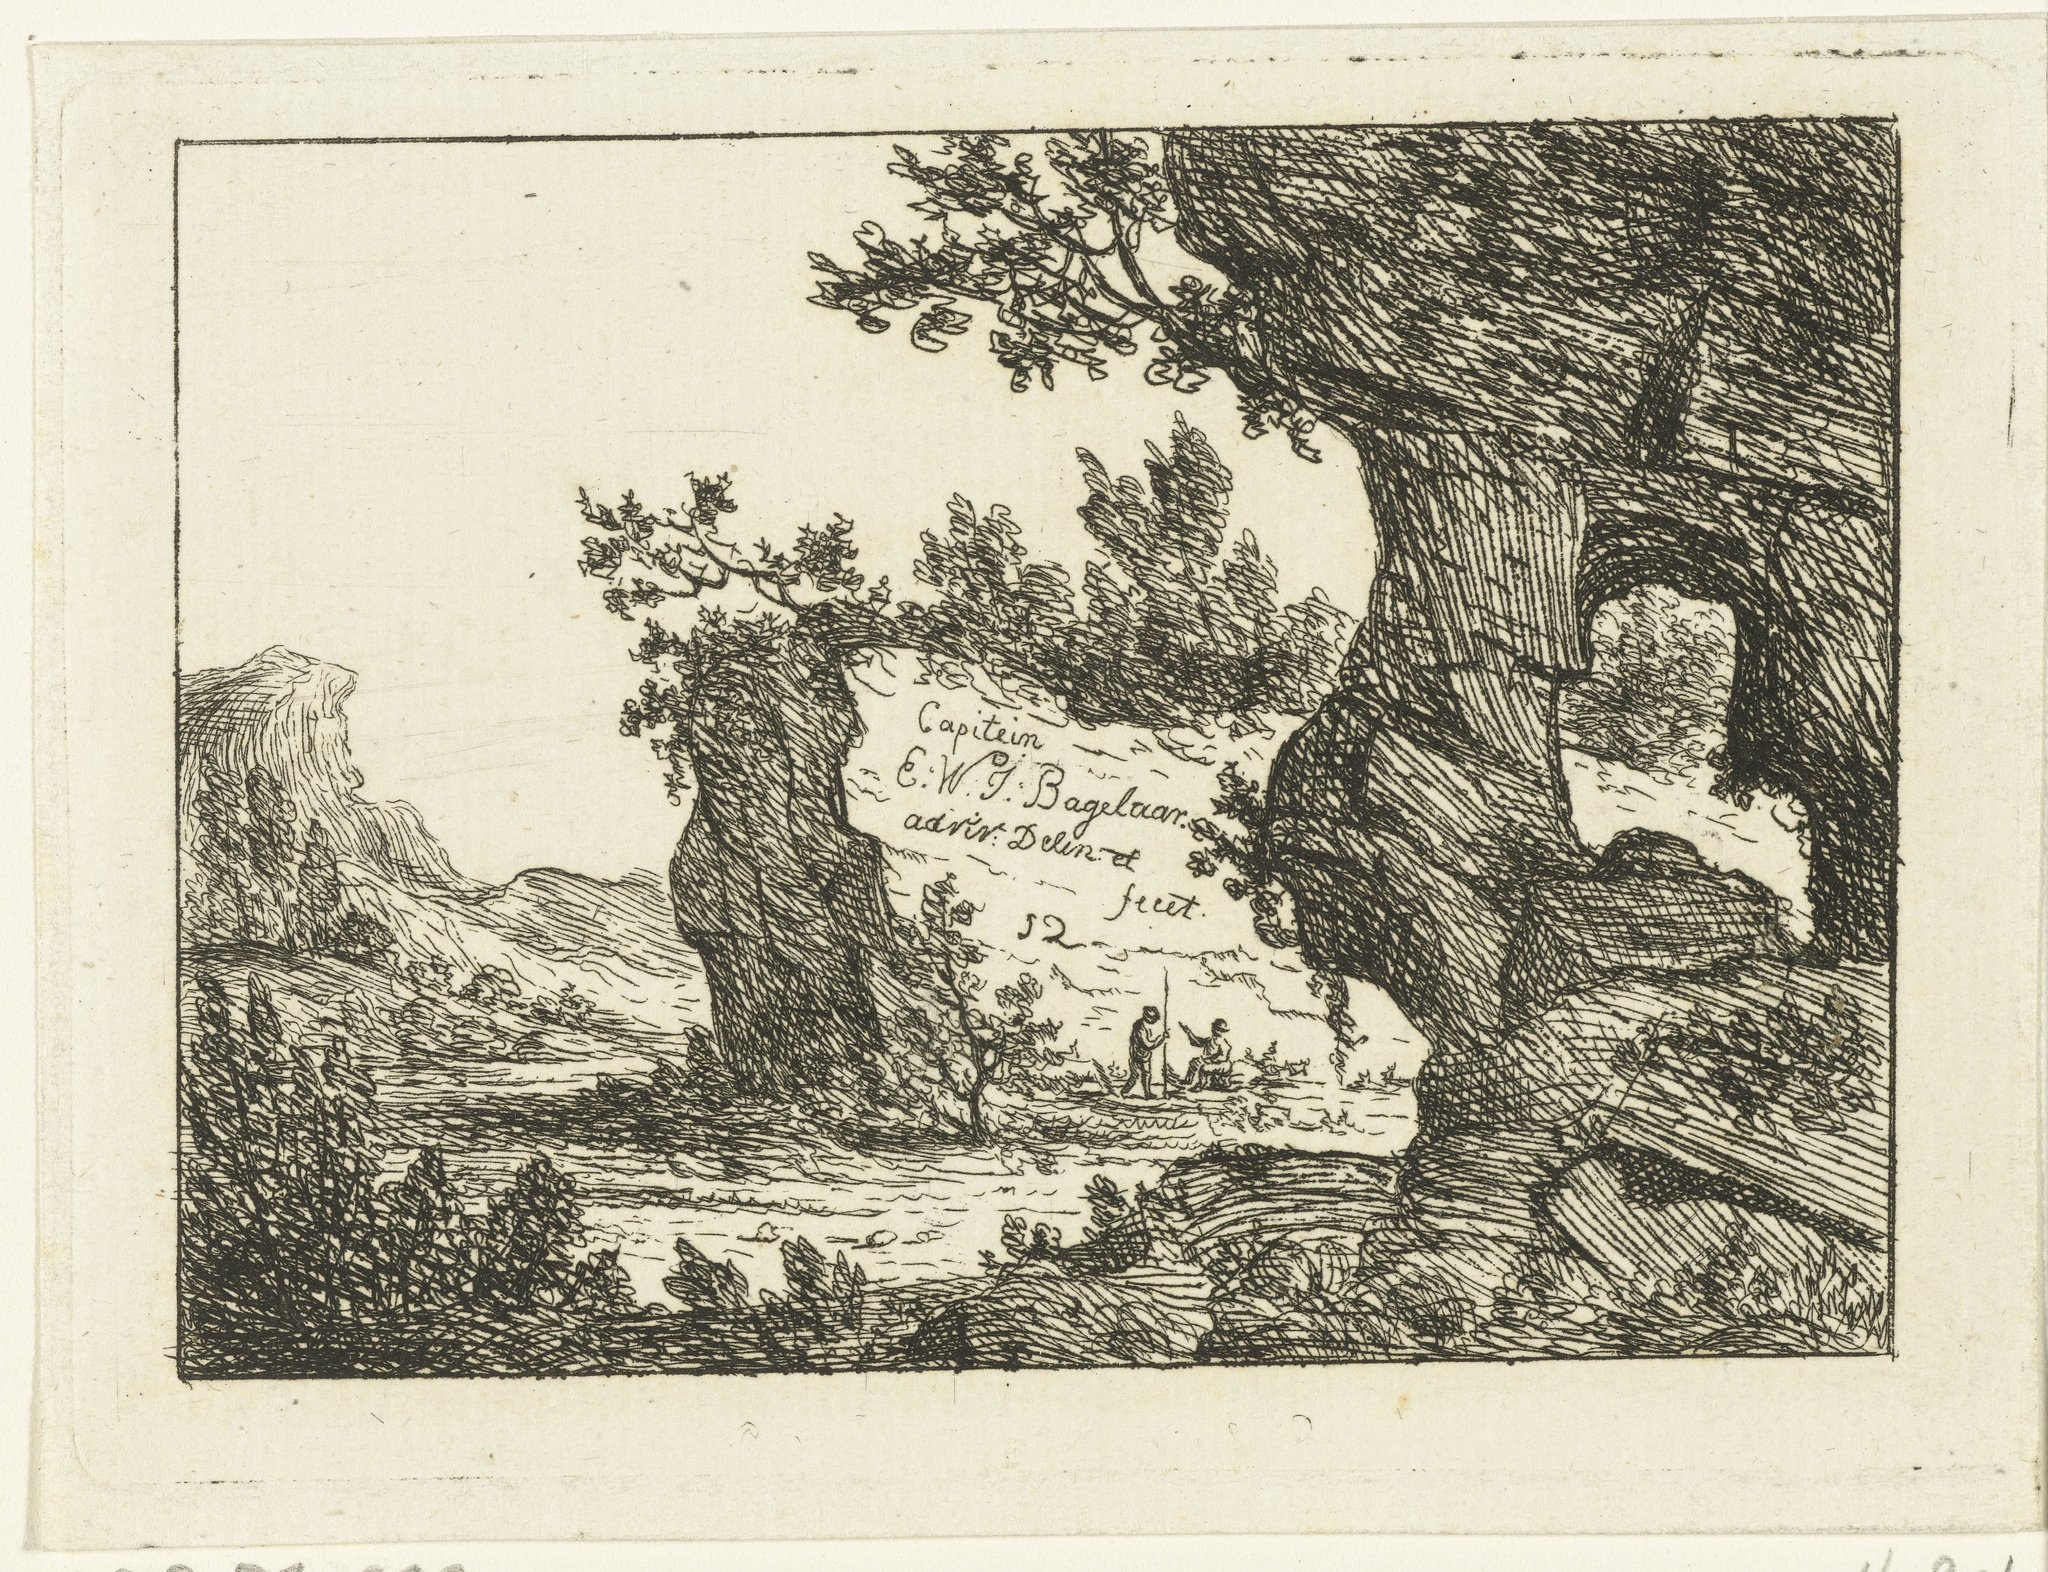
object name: print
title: Rotslandschap met twee wandelaars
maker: ernst willem jan bagelaar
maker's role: draughtsman, print maker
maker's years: 1775-1837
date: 1798-1837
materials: paper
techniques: etching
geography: netherlands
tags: rocks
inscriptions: collector's mark: Lugt 2228